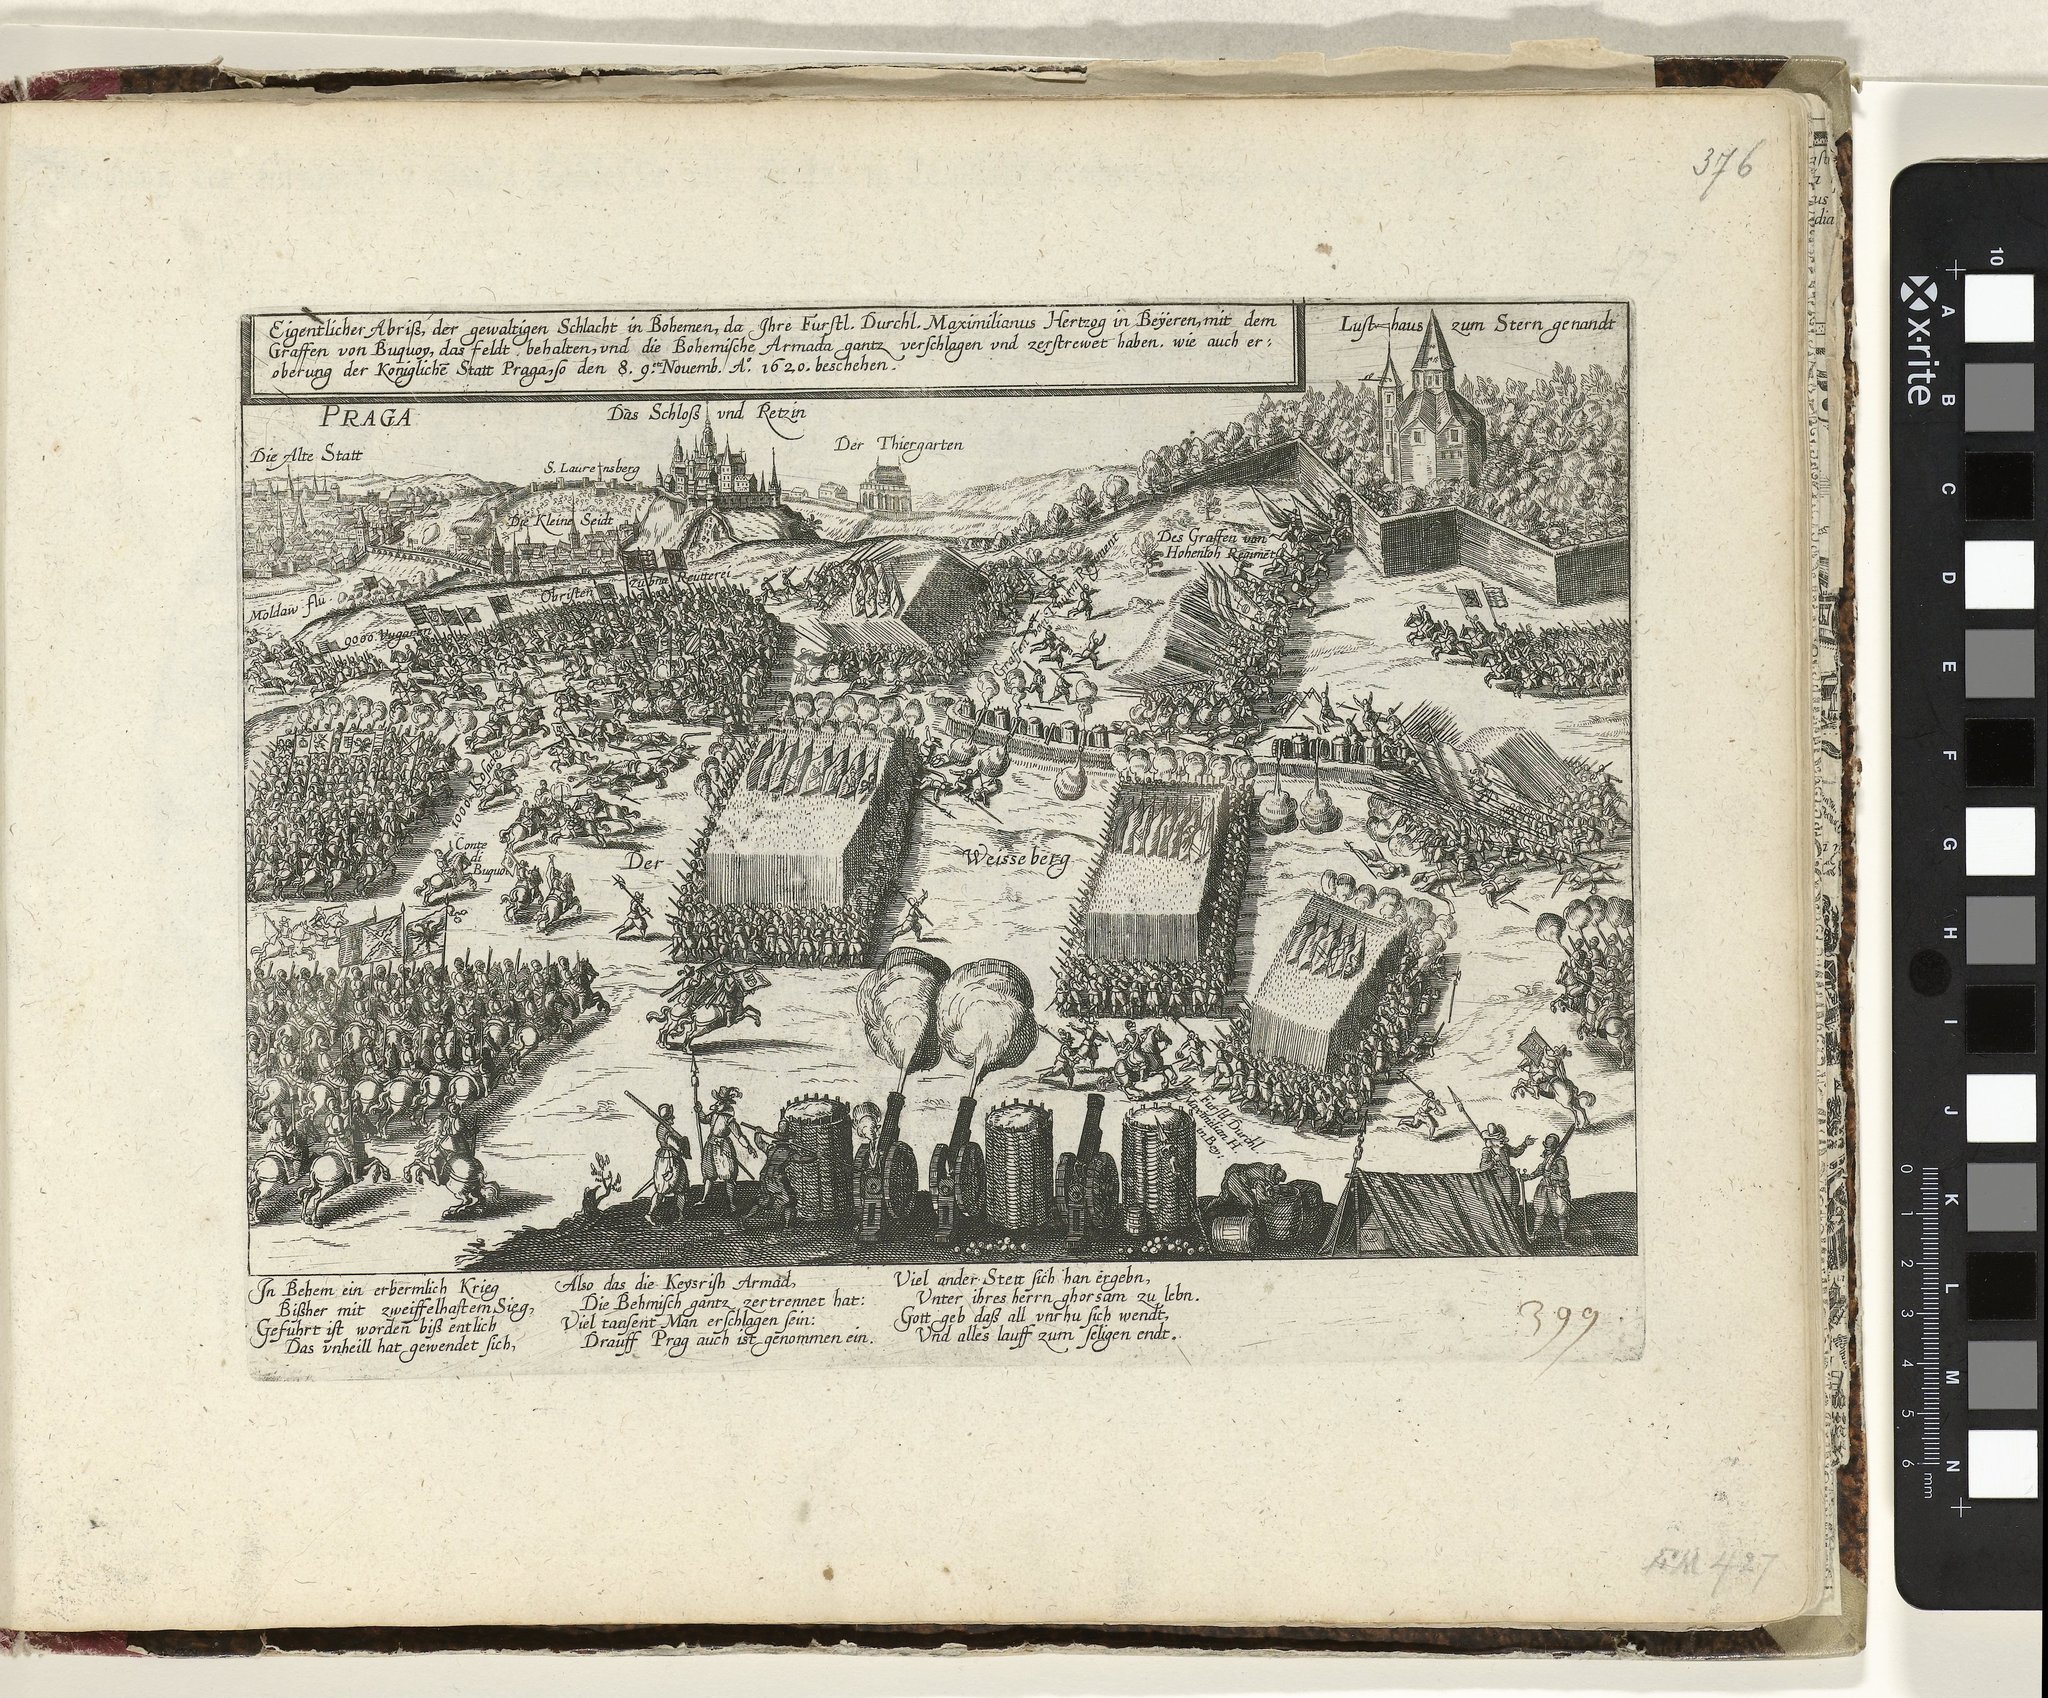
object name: album leaf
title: Slag op de Witte Berg bij Praag, 1620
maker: frans hogenberg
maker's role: print maker, publisher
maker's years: 1538-1590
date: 1620-1622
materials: paper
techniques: etching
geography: cologne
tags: battle, fighting in general, prague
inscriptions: inscription: ‘399’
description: Slag bij de Witten Berg (Weißen Berg) bij Praag, 8-9 november 1620. Met onderschrift van 12 regels in het Duits. Rechtsonder met pen genummerd: 399. De prent maakt deel uit van een album.